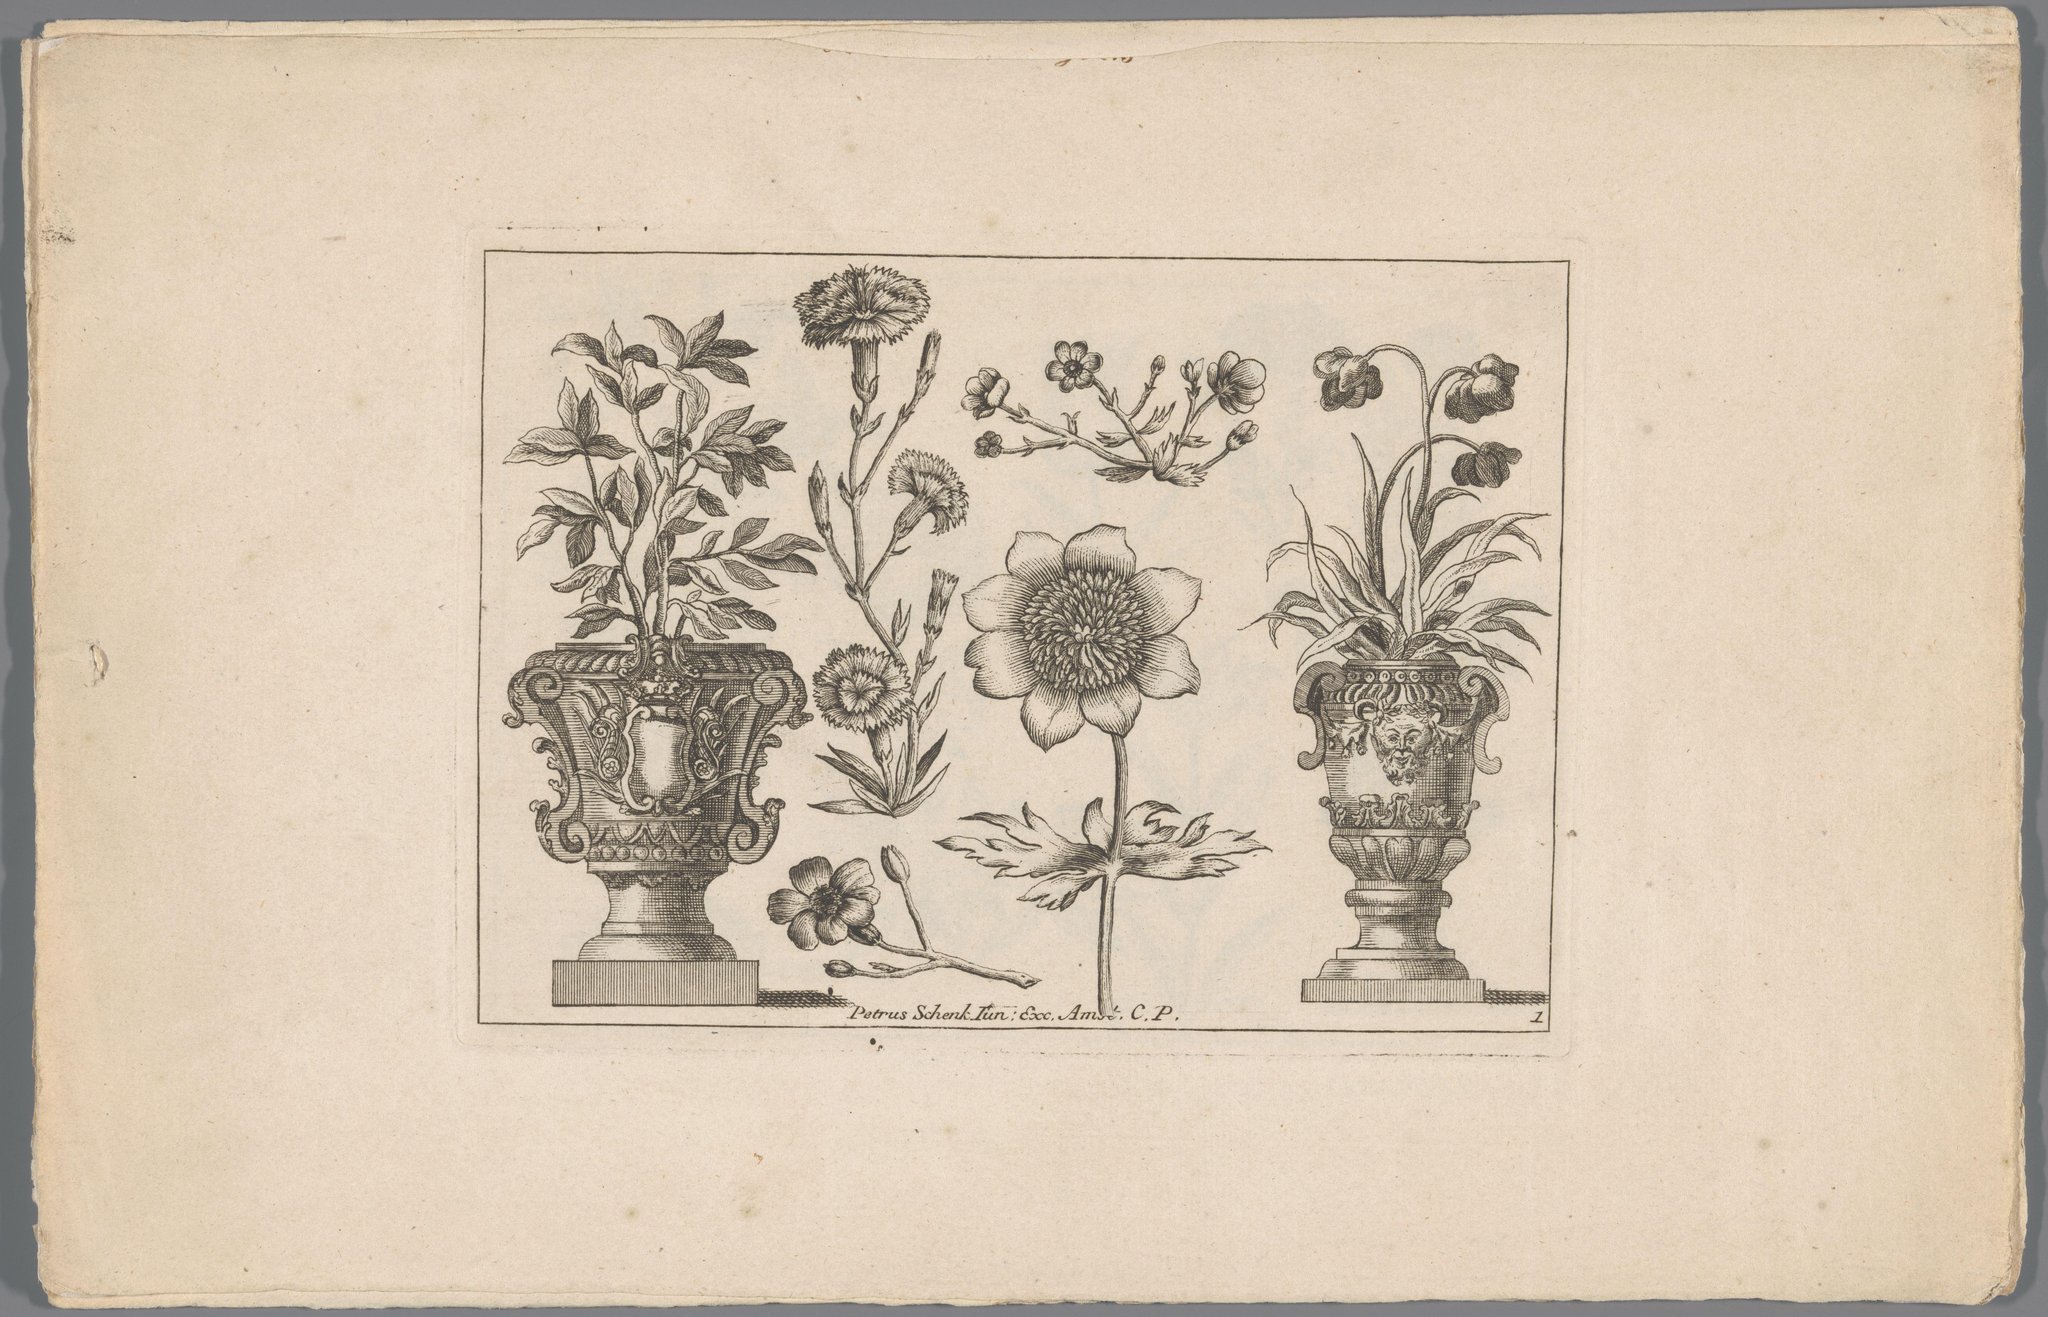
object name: ornament print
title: Bloemen en vazen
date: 1705-1730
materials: paper, fiber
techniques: engraving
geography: amsterdam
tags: flowers, vase ~ ornament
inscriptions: collector's mark: Lugt 2228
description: De prent maakt deel uit van een samengebonden, genummerde serie van acht prenten met bloemen. De serie bestond oorspronkelijk waarschijnlijk uit twaalf prenten.